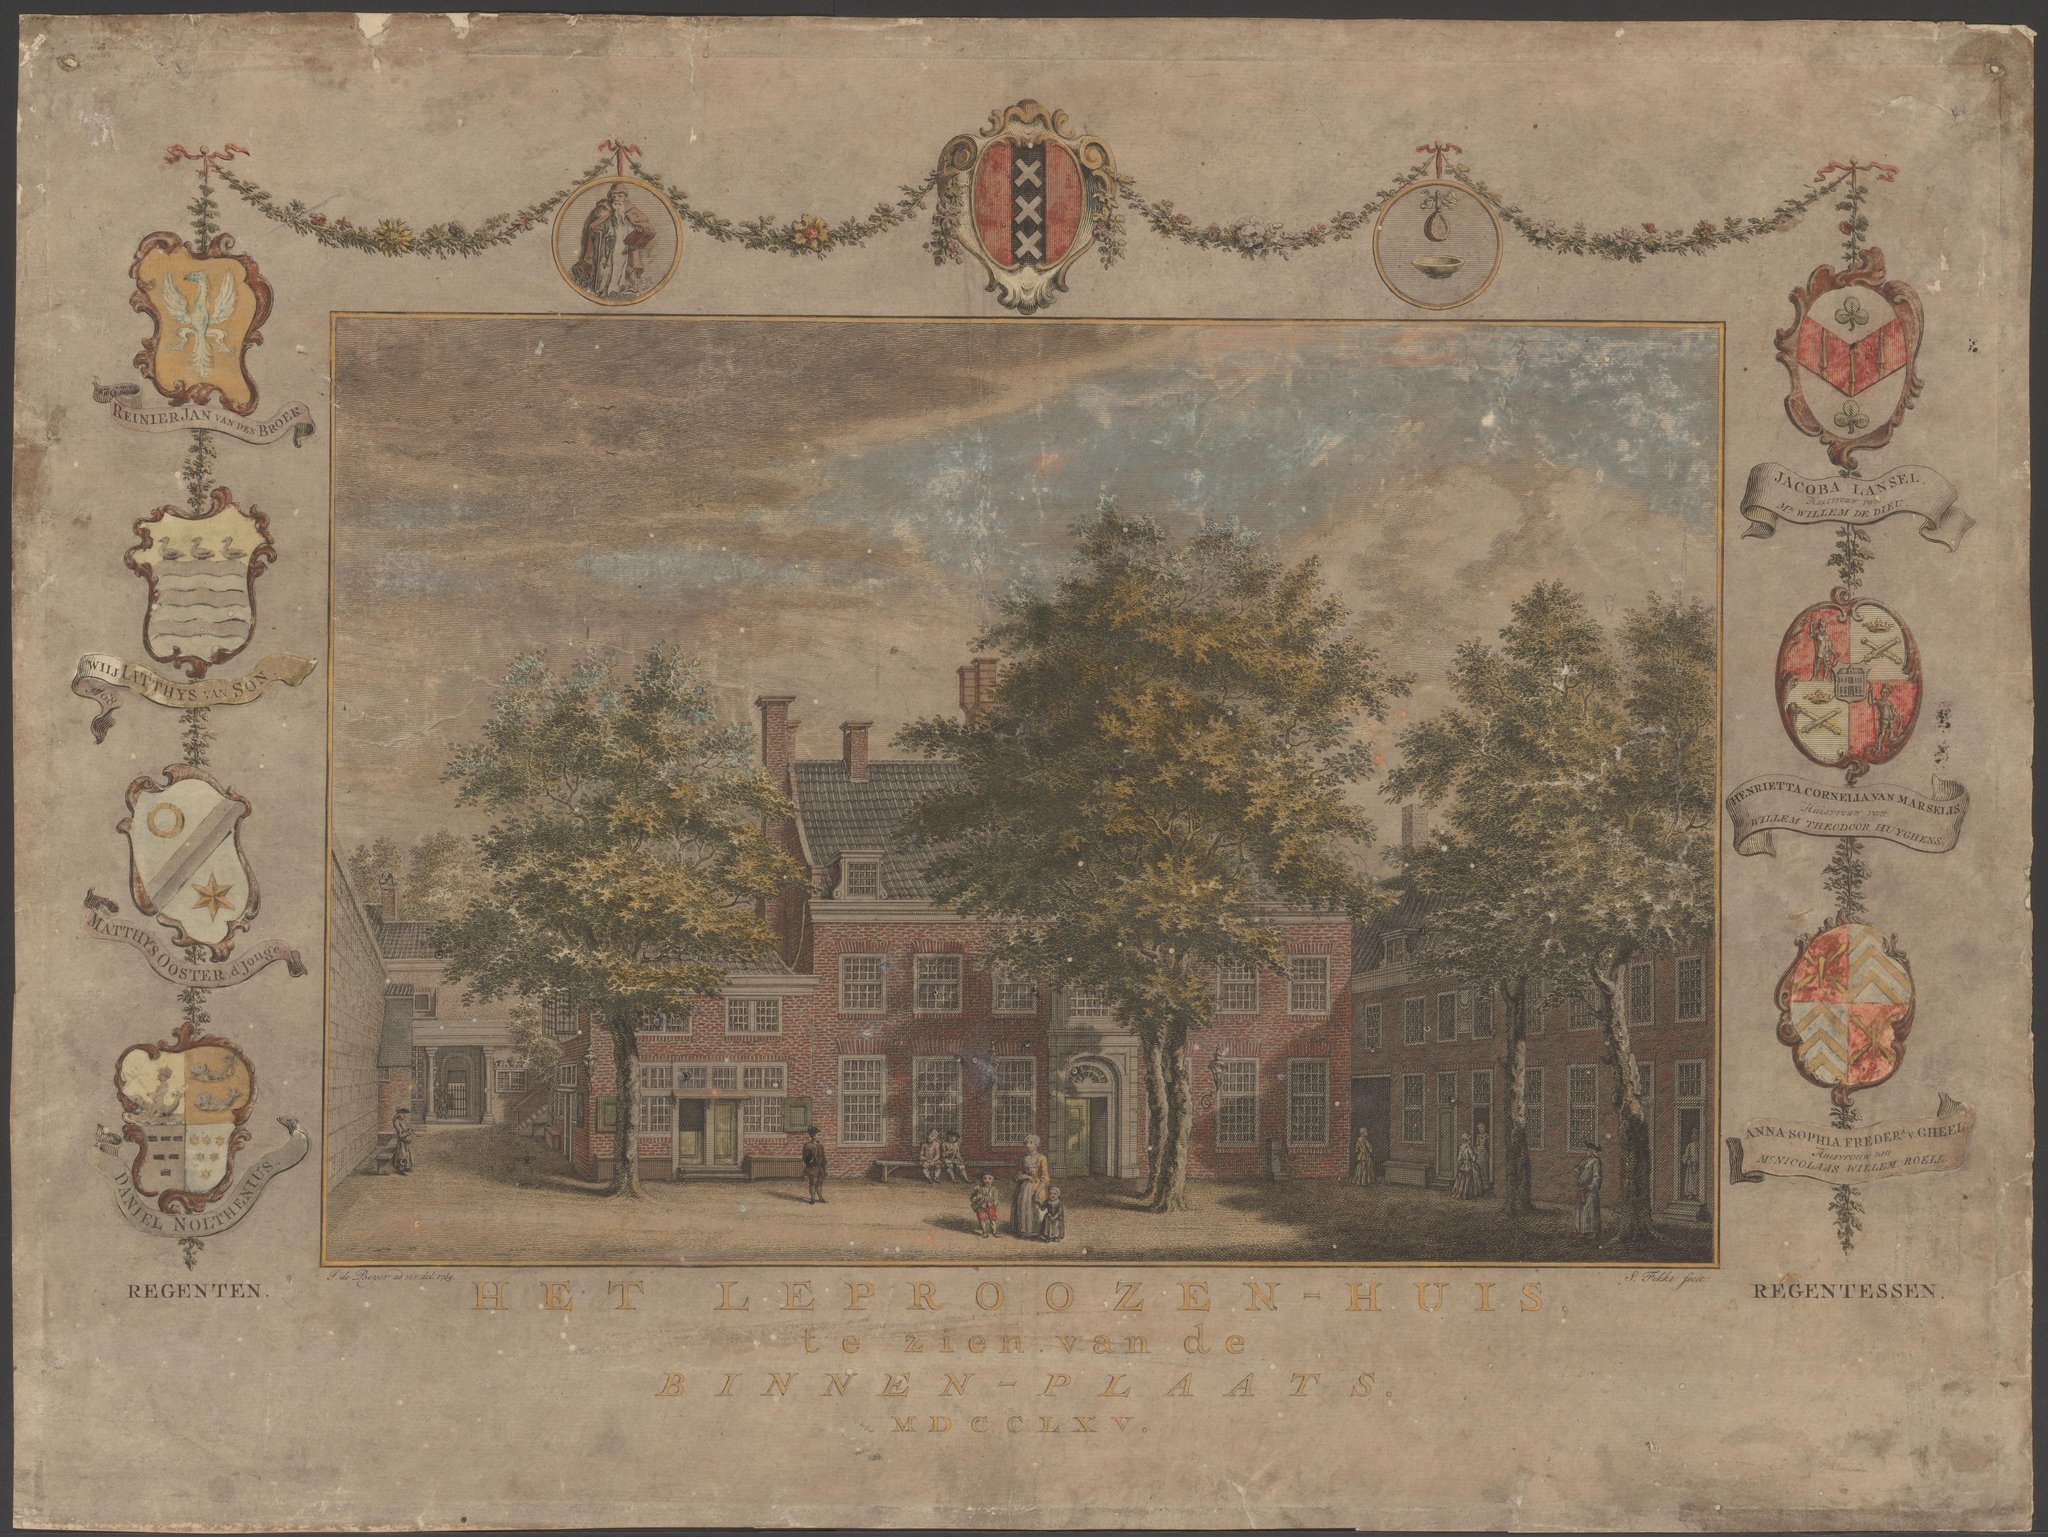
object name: print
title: Het Leproozen-Huis, te zien van de binnen-plaats. MDCCLXV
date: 1765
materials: paper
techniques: engraving, etching, hand coloring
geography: amsterdam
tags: coat of arms (as symbol of the state, etc.) (+ city; municipal), leprosarium, ornament ~ medallion, hospital, courtyard, armorial bearing, heraldry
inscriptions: collector's mark: Lugt 1641b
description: Gezicht op de binnenplaats van het Leprozenhuis te Amsterdam, gelegen aan de Lazarussteeg tegenover de Portugese Synagoge, 1765. Rond de voorstelling een guirlande, met aan de zijkanten de deels geplakte wapens van de regenten en regentessen uit het jaar 1768 en bovenaan een medaillon met Sint-Antonius, het wapen van Amsterdam en een medaillon met een leprozenklepper en een bedelnap. Onderwerpsrubriek binnen de Atlas Amsterdam: Armwezen en liefdadige instellingen: I. Stadsinrichtingen: Leprozen- of Lazarushuis, omgang van leprozen, regenten.